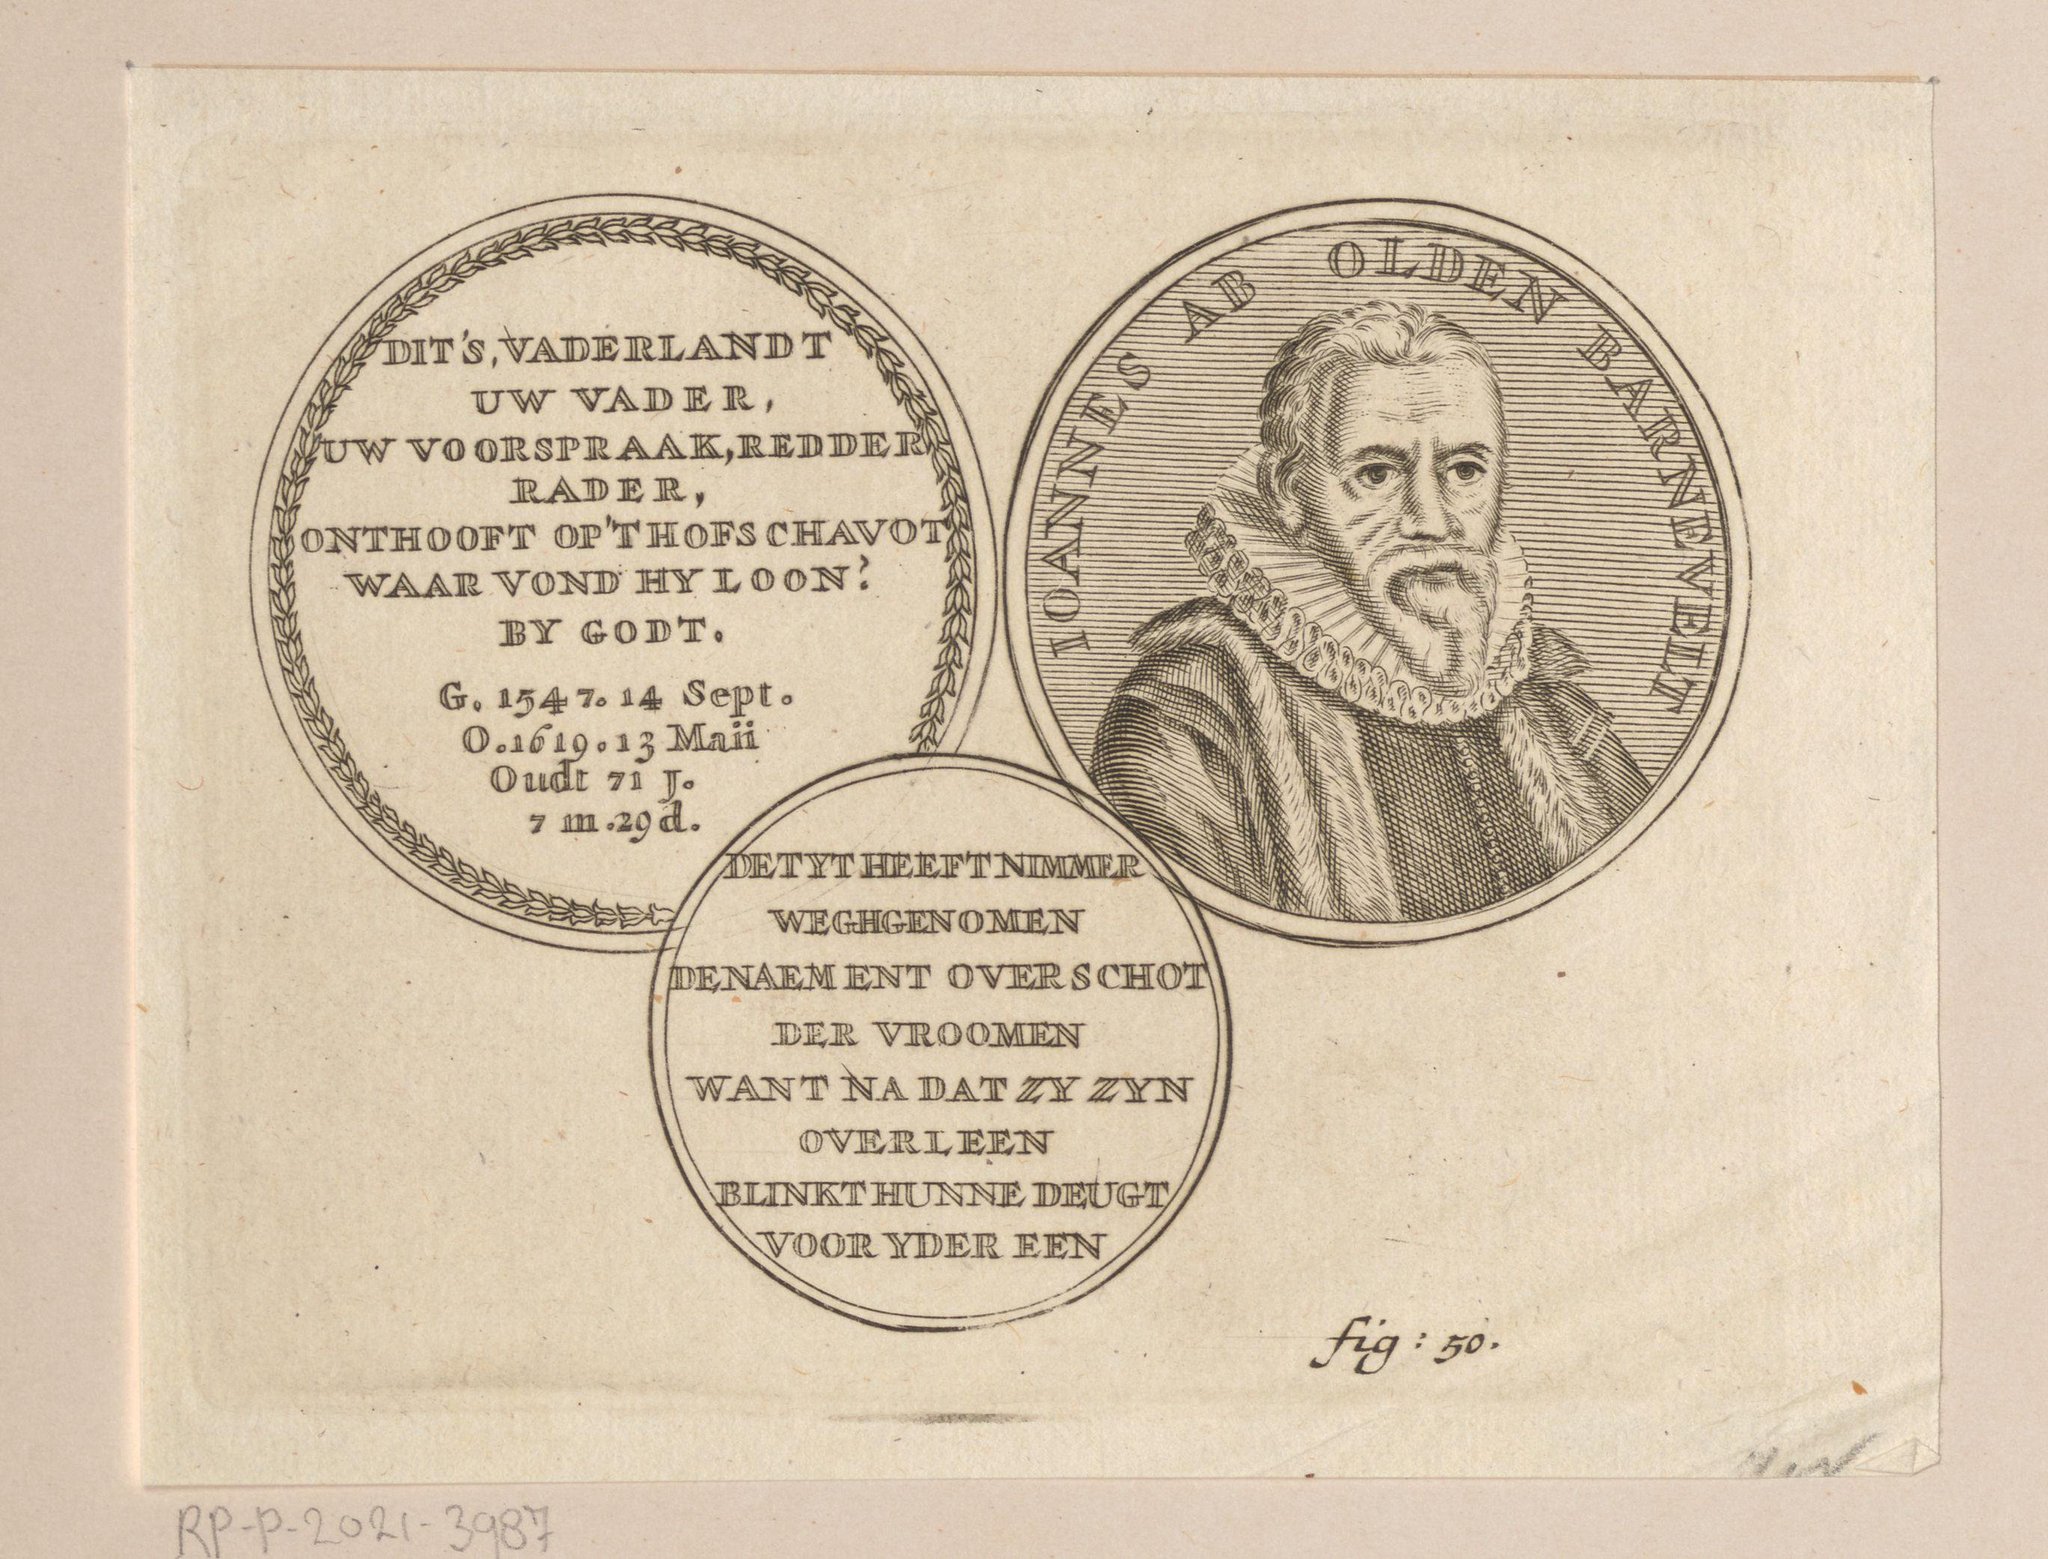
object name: print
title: Portret van Johan van Oldenbarnevelt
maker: Anonymous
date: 1690-1723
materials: paper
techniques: engraving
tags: the hague, johan van oldenbarnevelt, historical persons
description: Prent zonder nummering gebruikt in: Bizot, Pierre. Medalische historie der republyk van Holland. Amsterdam: Pieter Mortier, 1690, dl. 1. Prent ook gebruikt in latere publicaties (1723).